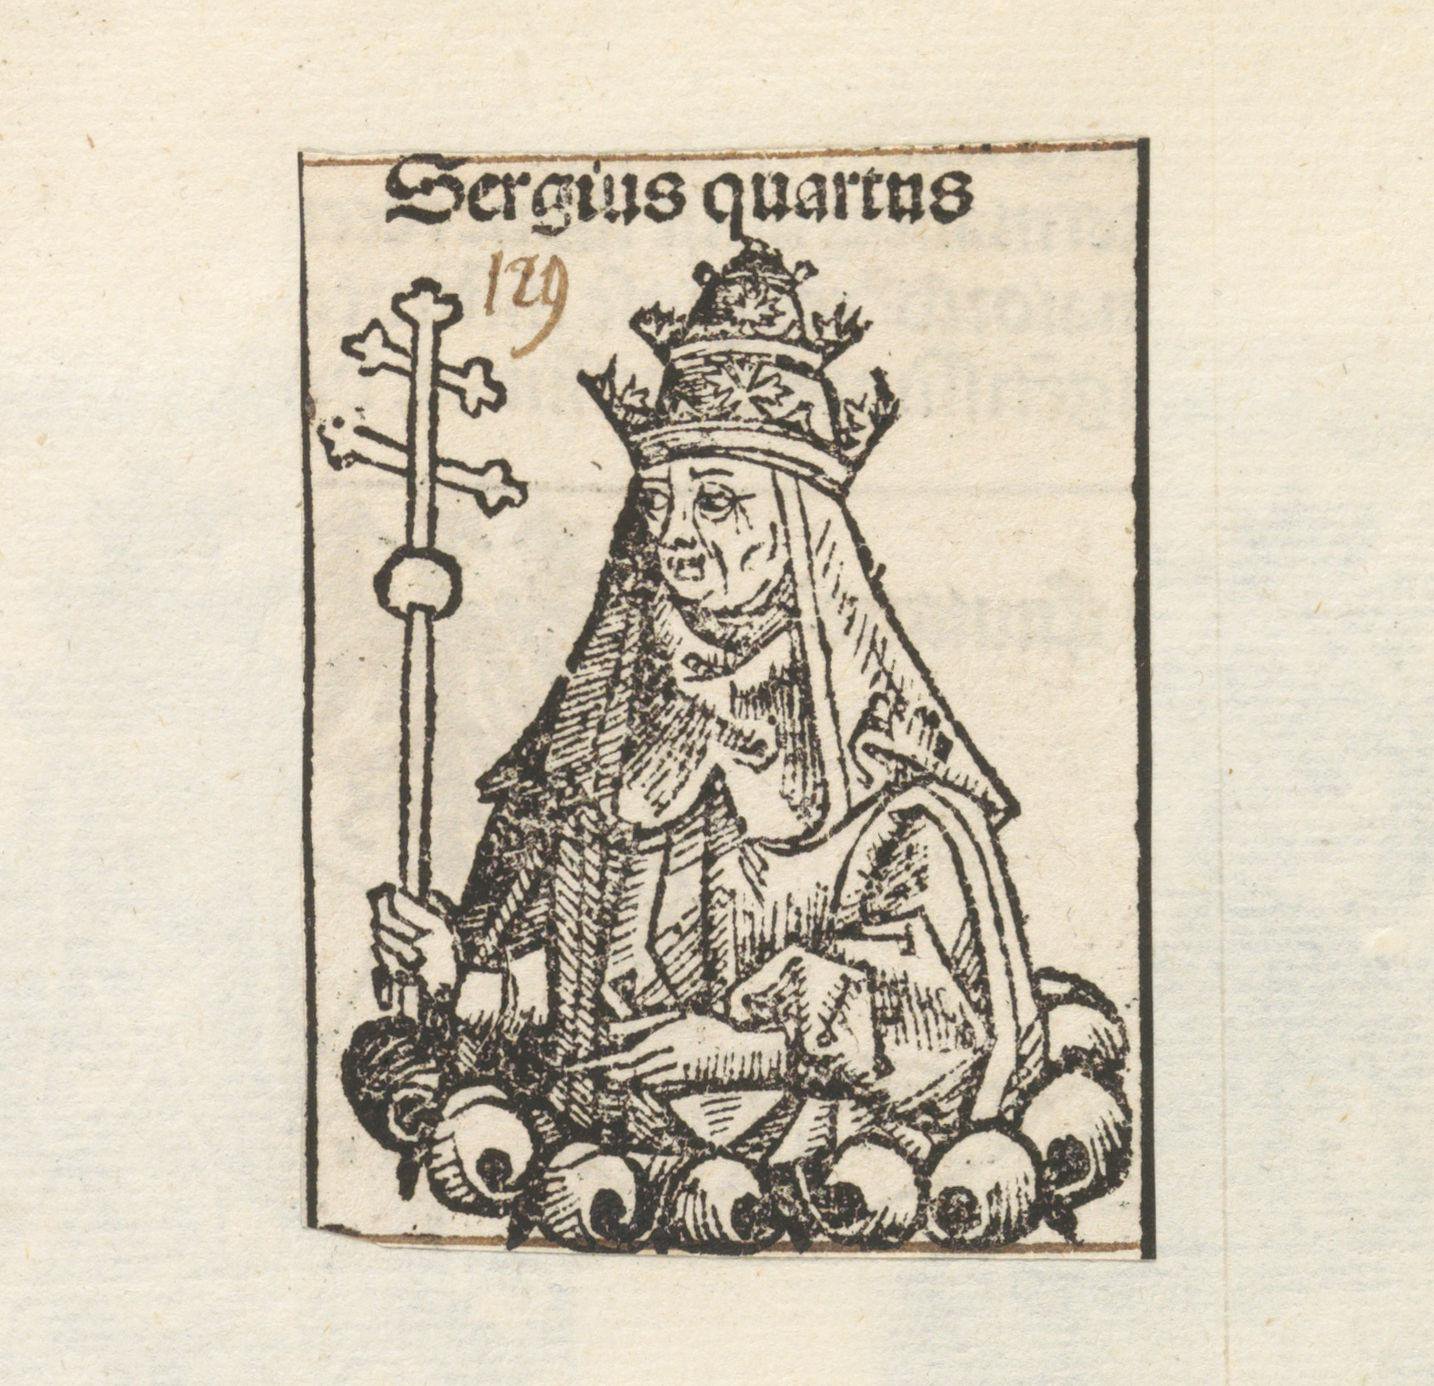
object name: album leaf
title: Liber Chronicarum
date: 1493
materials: paper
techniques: letterpress printing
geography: nuremberg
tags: pope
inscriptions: inscription: ‘129’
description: Een bloemkelk met een paus. Hij draagt een tiara en heeft een staf met dubbel kruis in zijn handen. De voorstelling is onderdeel van de opeenvolging pausen in de Liber Chronicarum. De tekst identificeert de man als Sergius IV. De prent maakt deel uit van een album.